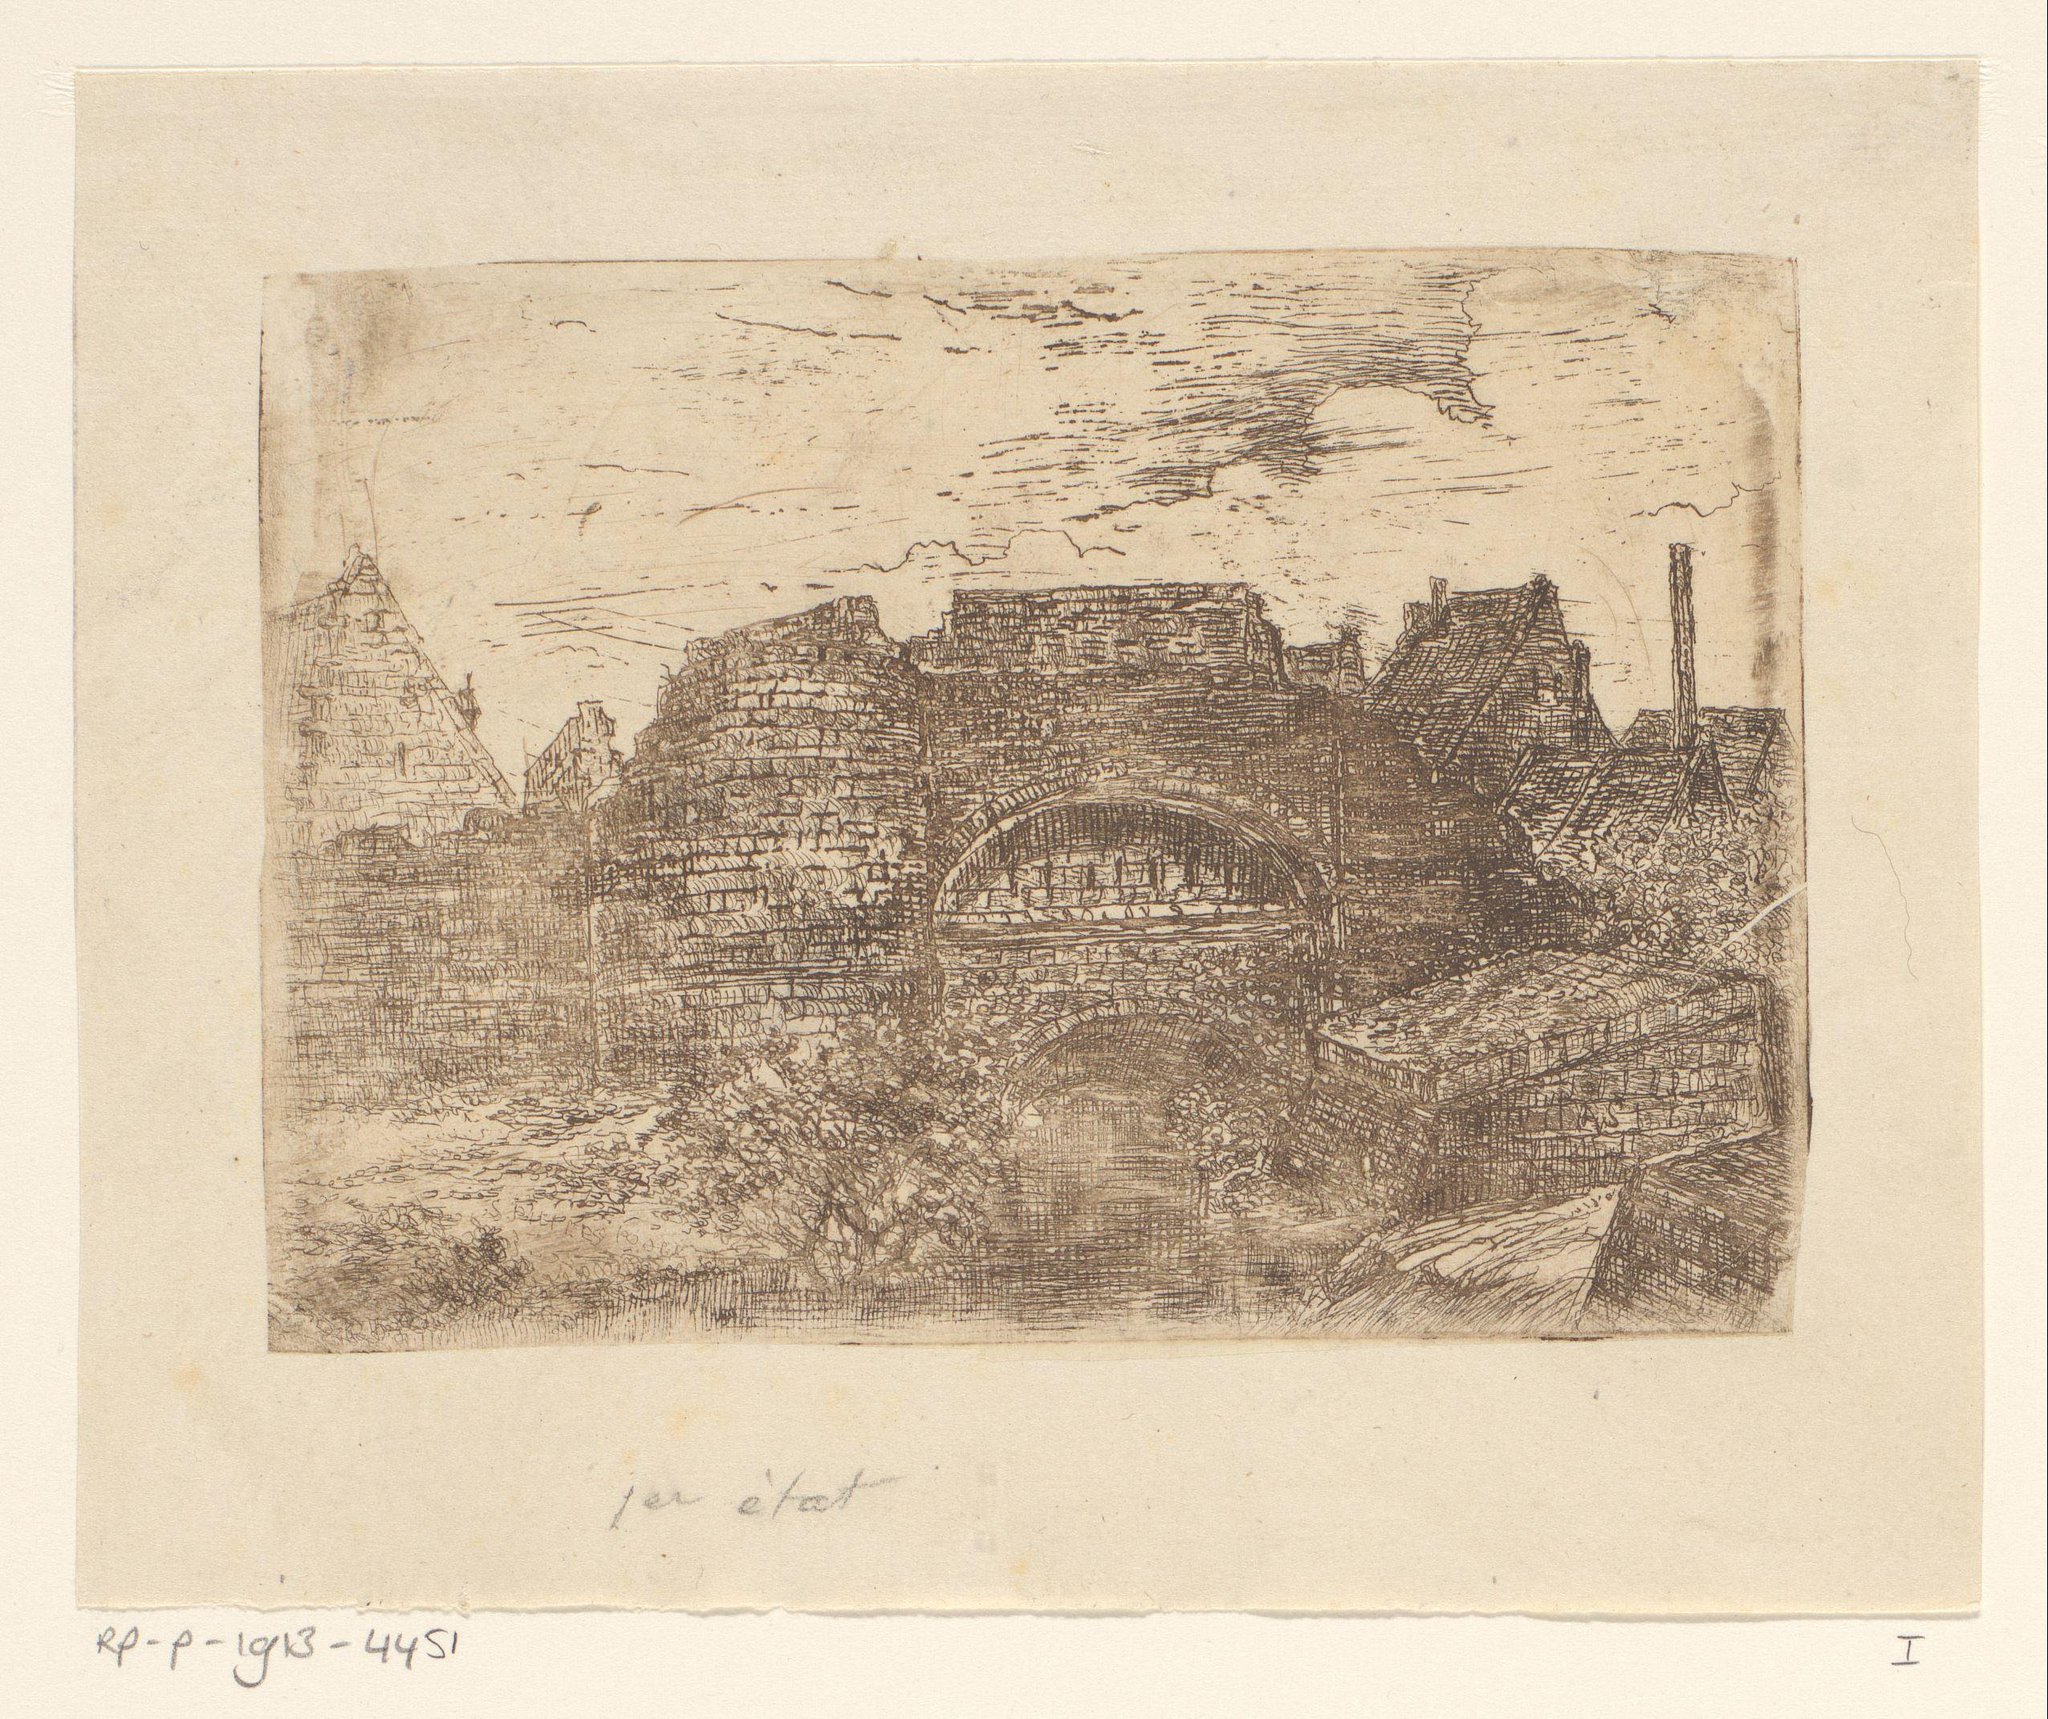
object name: print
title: Ruïnes van wallen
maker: alexander schaepkens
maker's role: draughtsman, print maker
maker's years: 1815-1899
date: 1830-1899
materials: paper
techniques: etching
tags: ruin of a building ~ architecture, walls ~ fortified city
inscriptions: collector's mark: Lugt 2228